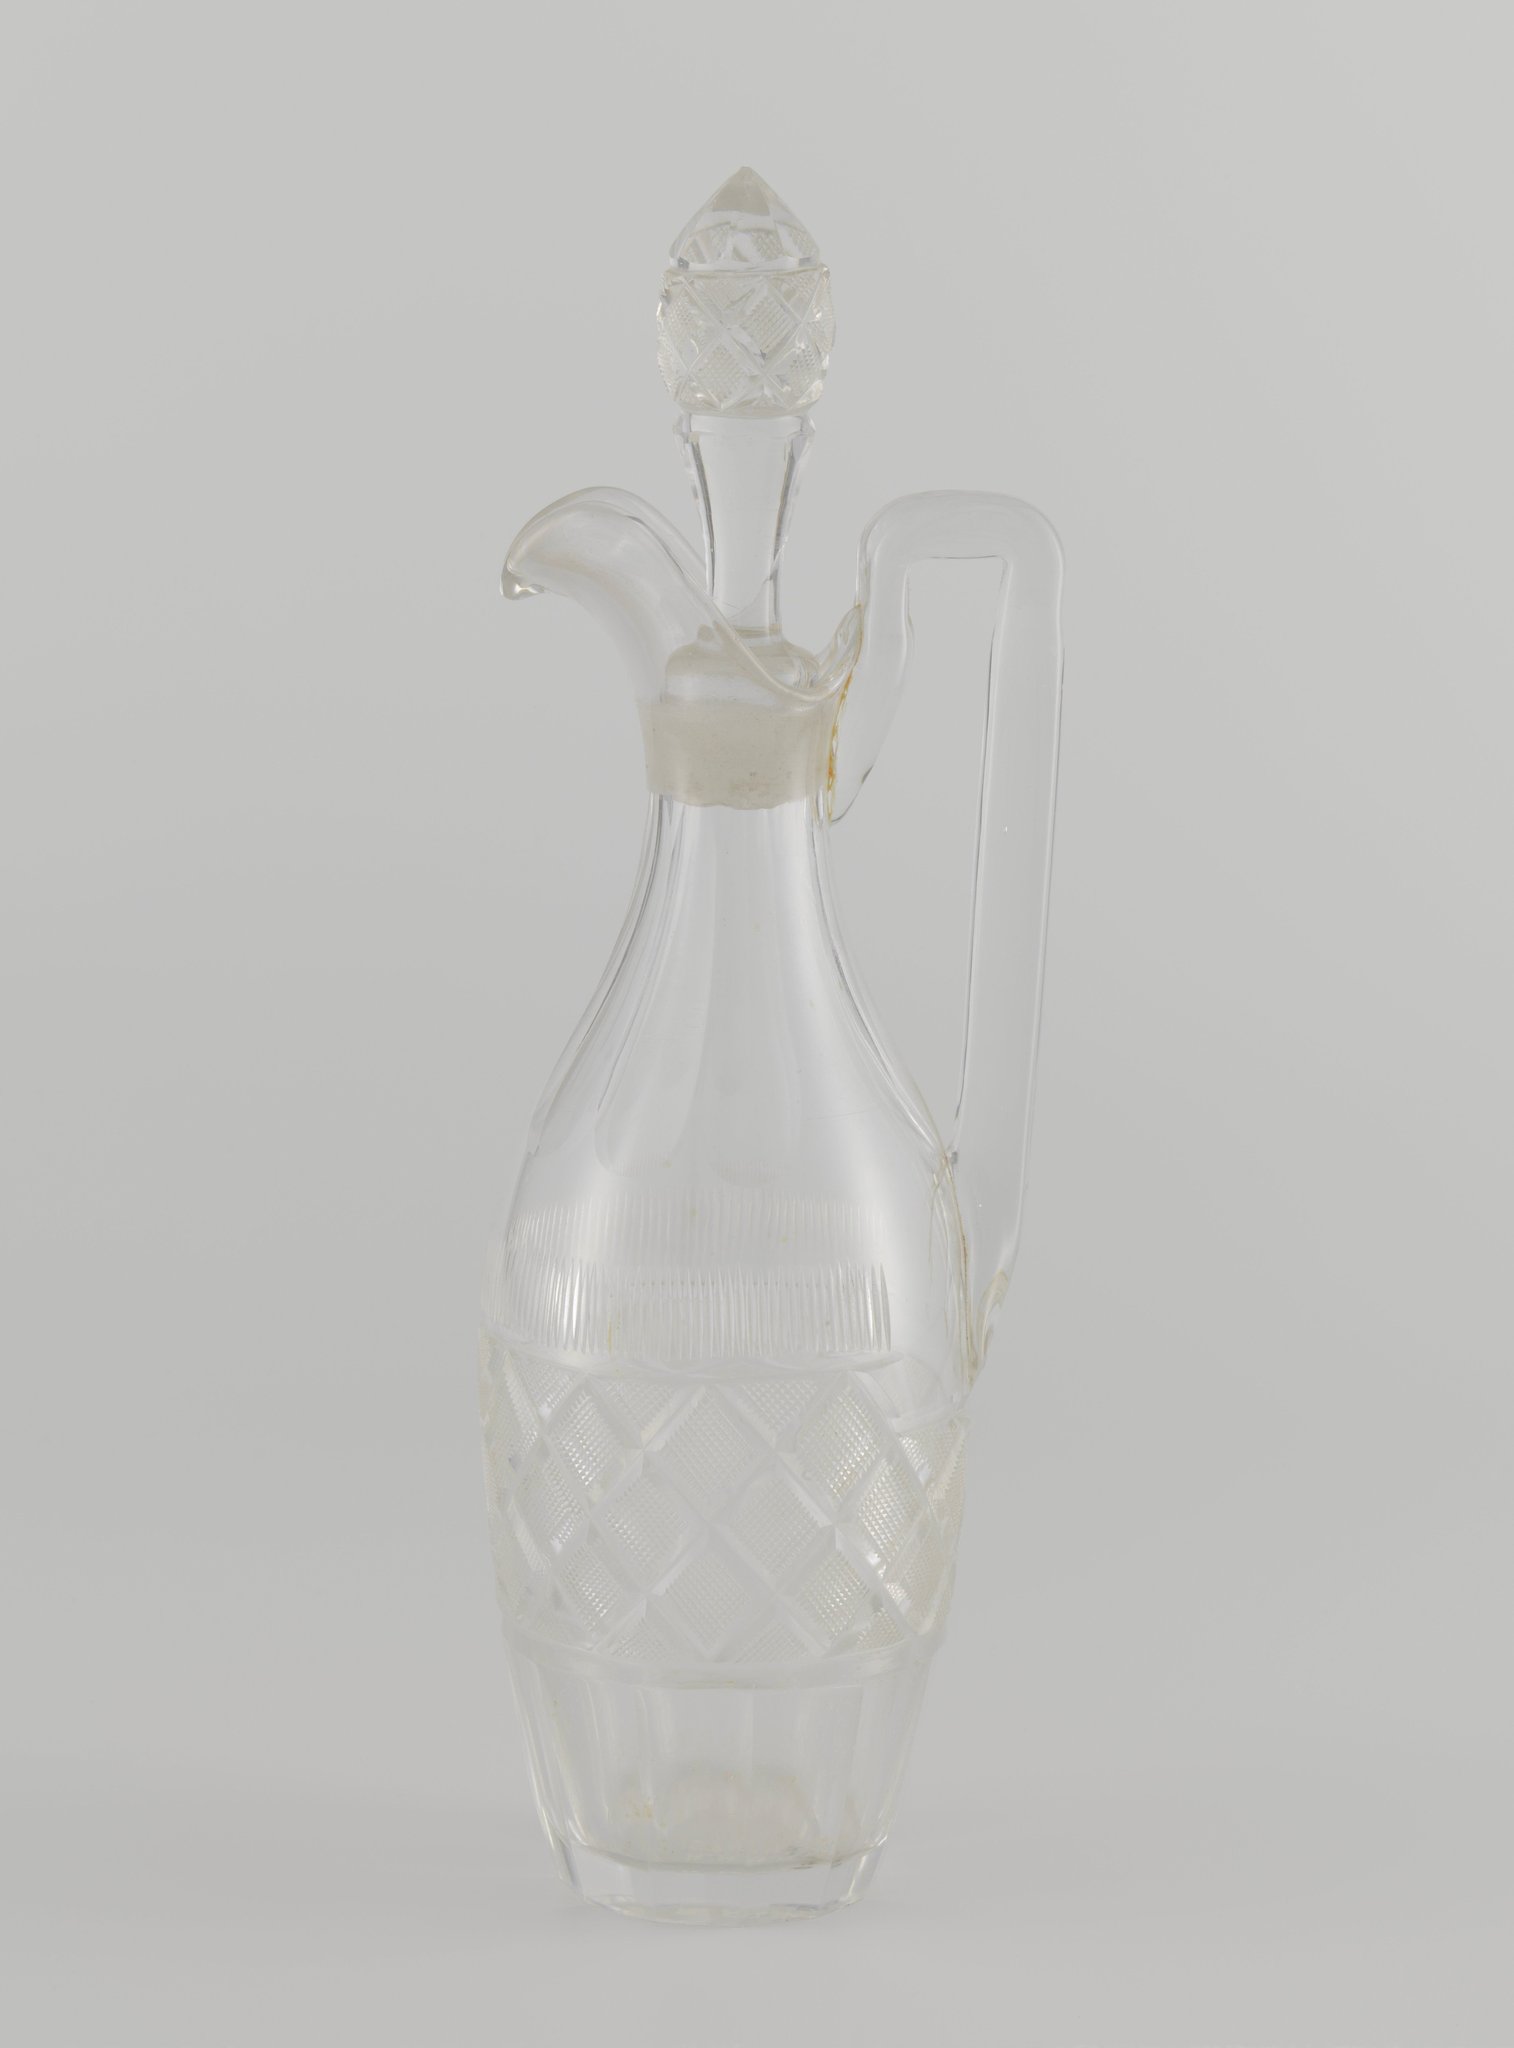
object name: cruet set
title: Fles met stop van olie- en azijnstel bestaande uit twee flessen van glas en een peperbus in een houder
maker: jan hendrik middelhuysen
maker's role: silversmith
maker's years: 1746-1822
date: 1783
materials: glass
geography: amsterdam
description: Fles met stop, versierd met divers slijpwerk. De smalle hals eindigd in een brede tuit. Het rechte oor loopt van bovenaan de hals naar de buik van de fles.